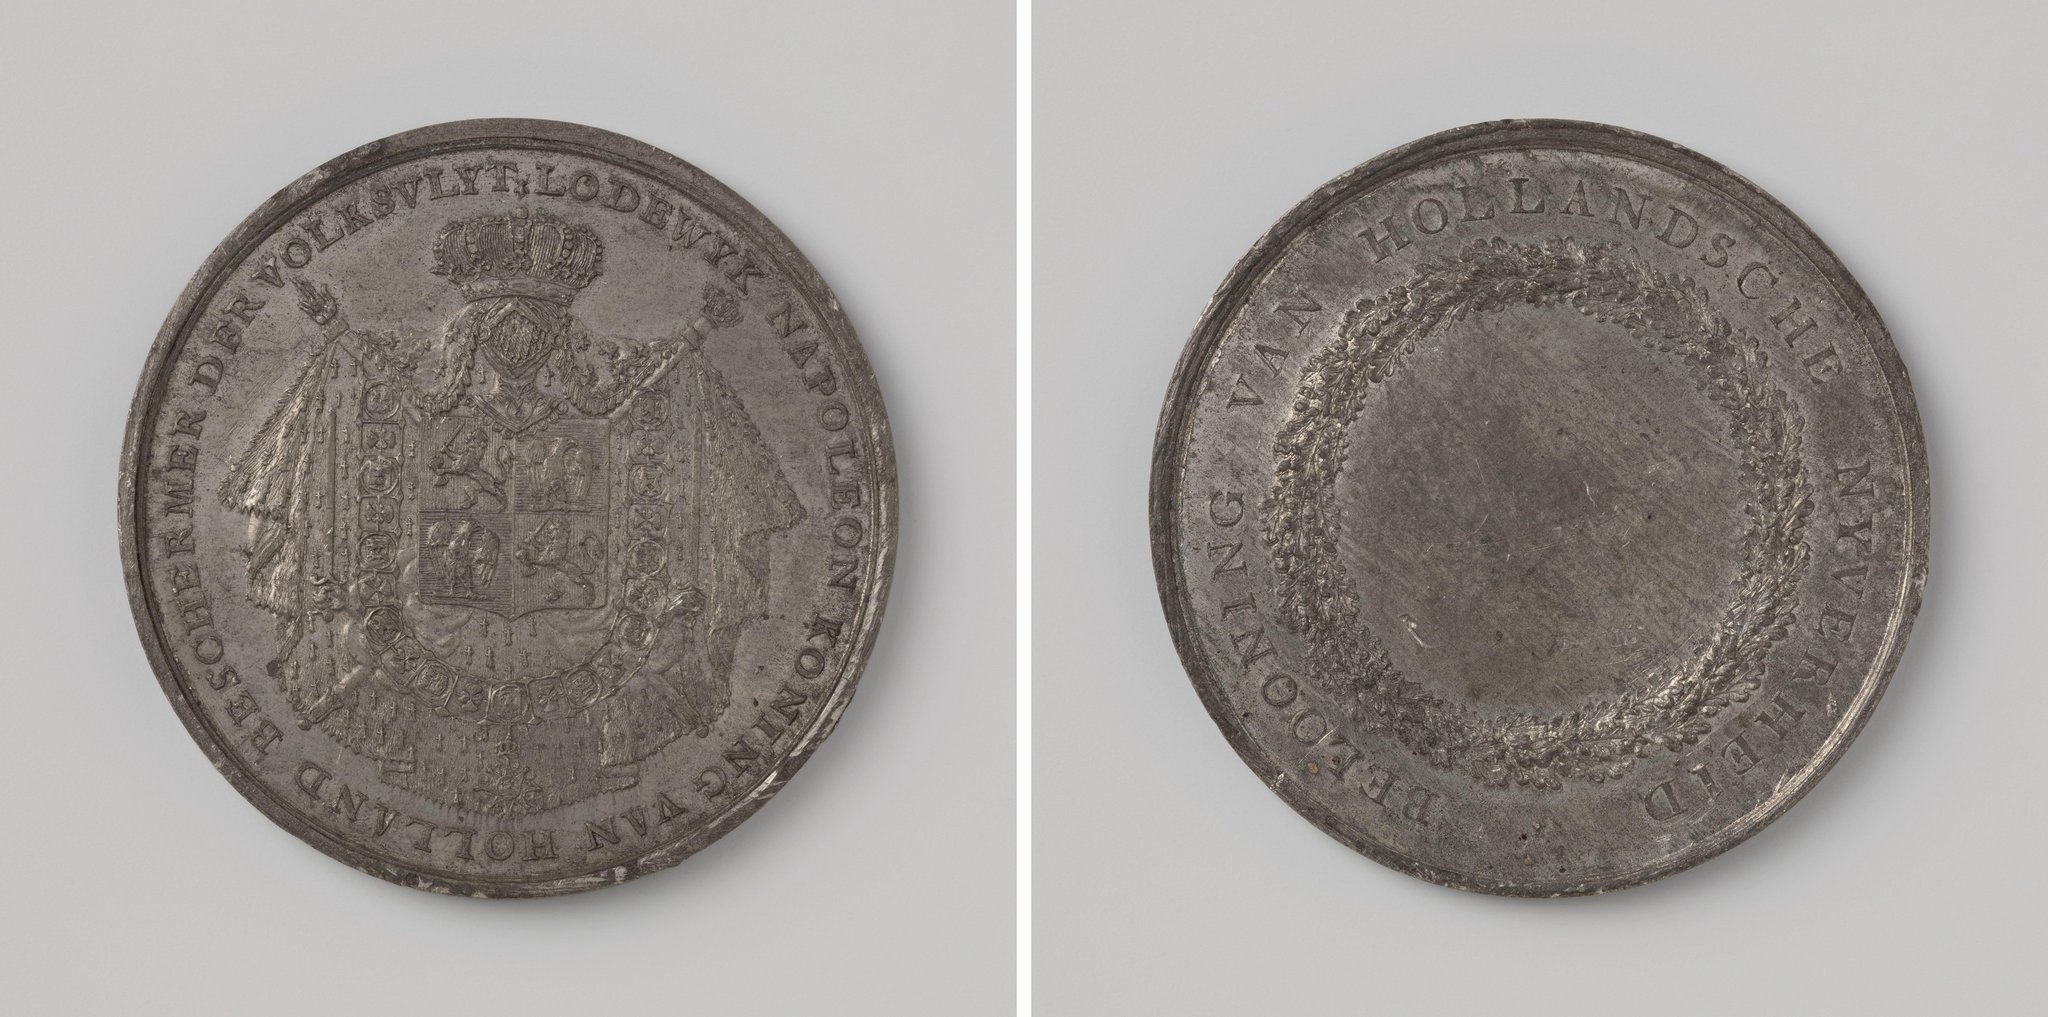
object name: medal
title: Hollandsche Nijverheid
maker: hendrik de heus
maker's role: medailleur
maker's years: -1838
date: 1808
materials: lead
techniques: striking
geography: amsterdam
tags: louis napoleon (king of holland), rotterdam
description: Loden penning. Voorzijde: gekroond wapenschild, omhangen met grootkruis van de Orde van de Unie binnen omschrift. Keerzijde: blanco veld binnen eikekrans en omschrift